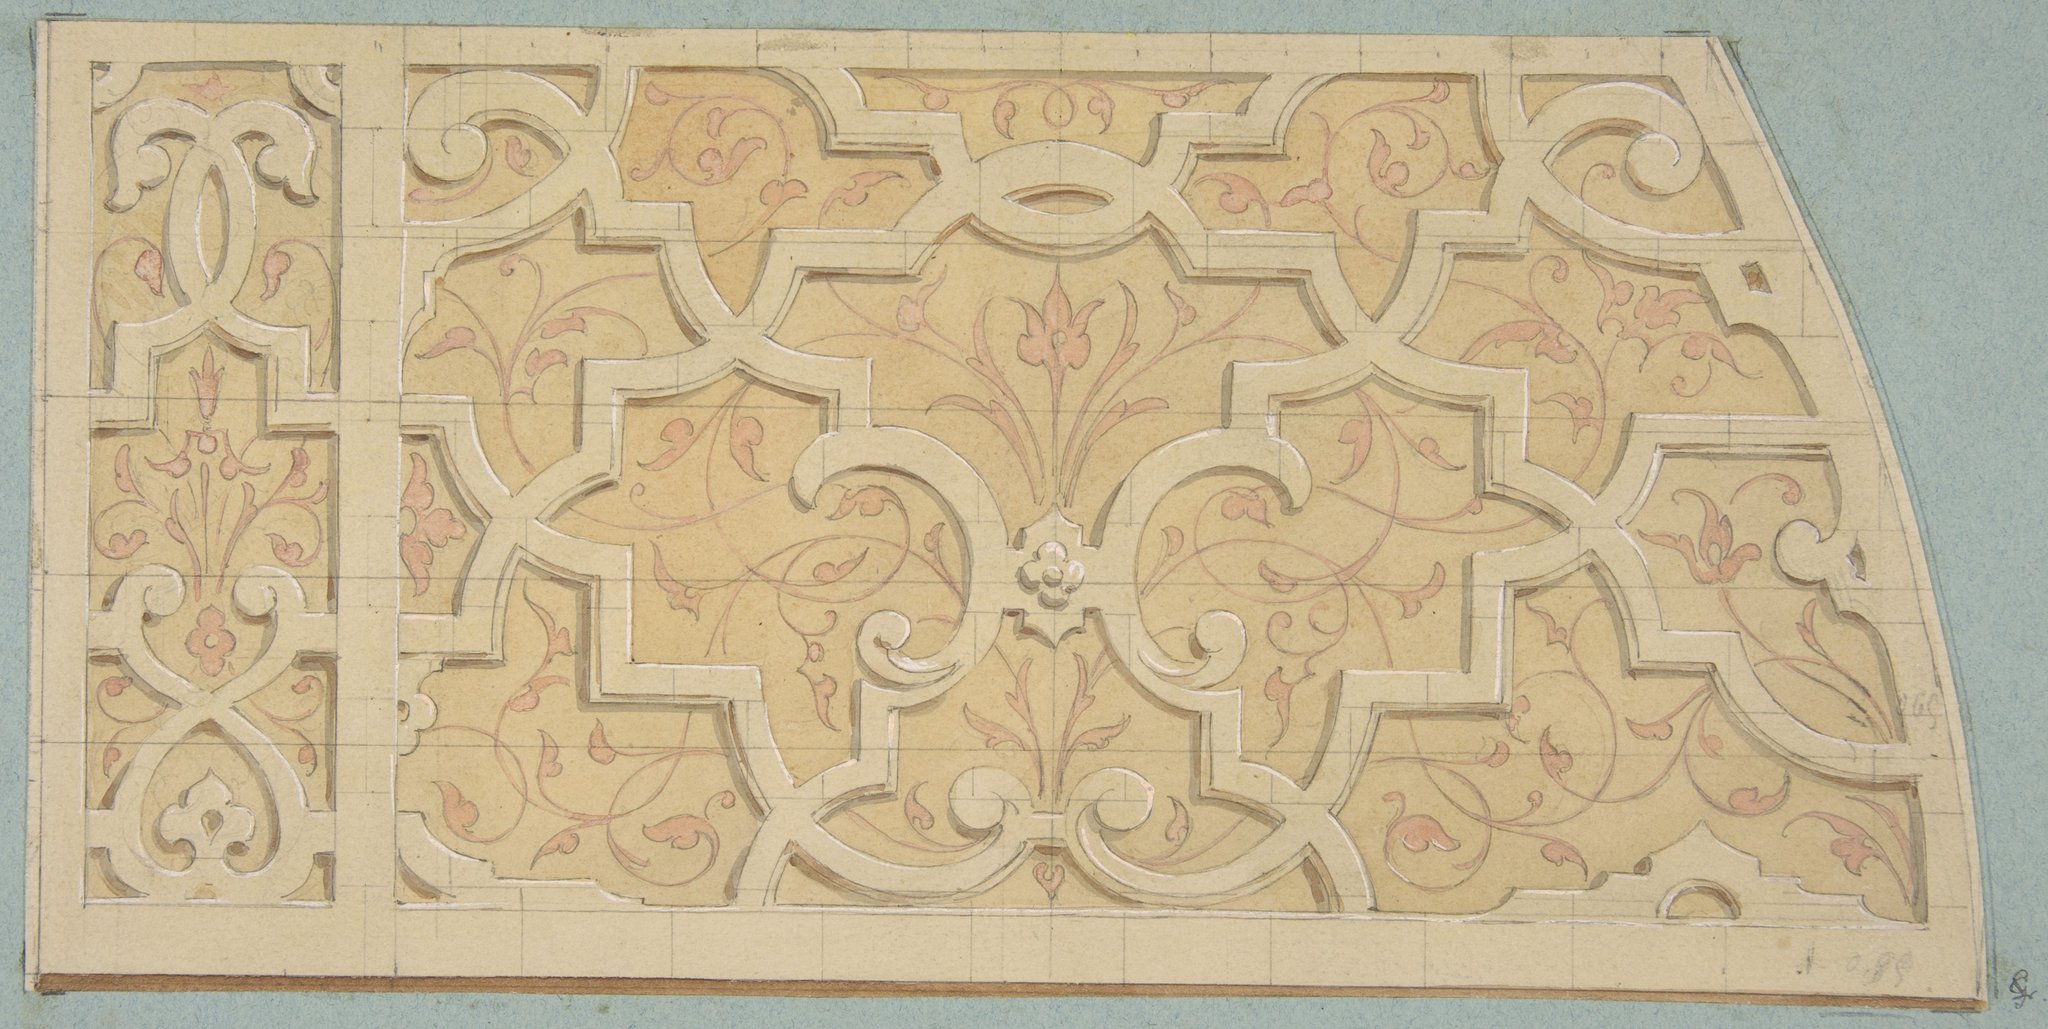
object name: drawing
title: Design for the decoration of the stairway in the Chateau d'Ognon of M. de Machy (Oise, France)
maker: jules-edmond-charles lachaise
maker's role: artist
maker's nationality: french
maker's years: 1897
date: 1851-1900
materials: graphite, watercolor, paper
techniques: heightening, inlay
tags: flowers,leaves